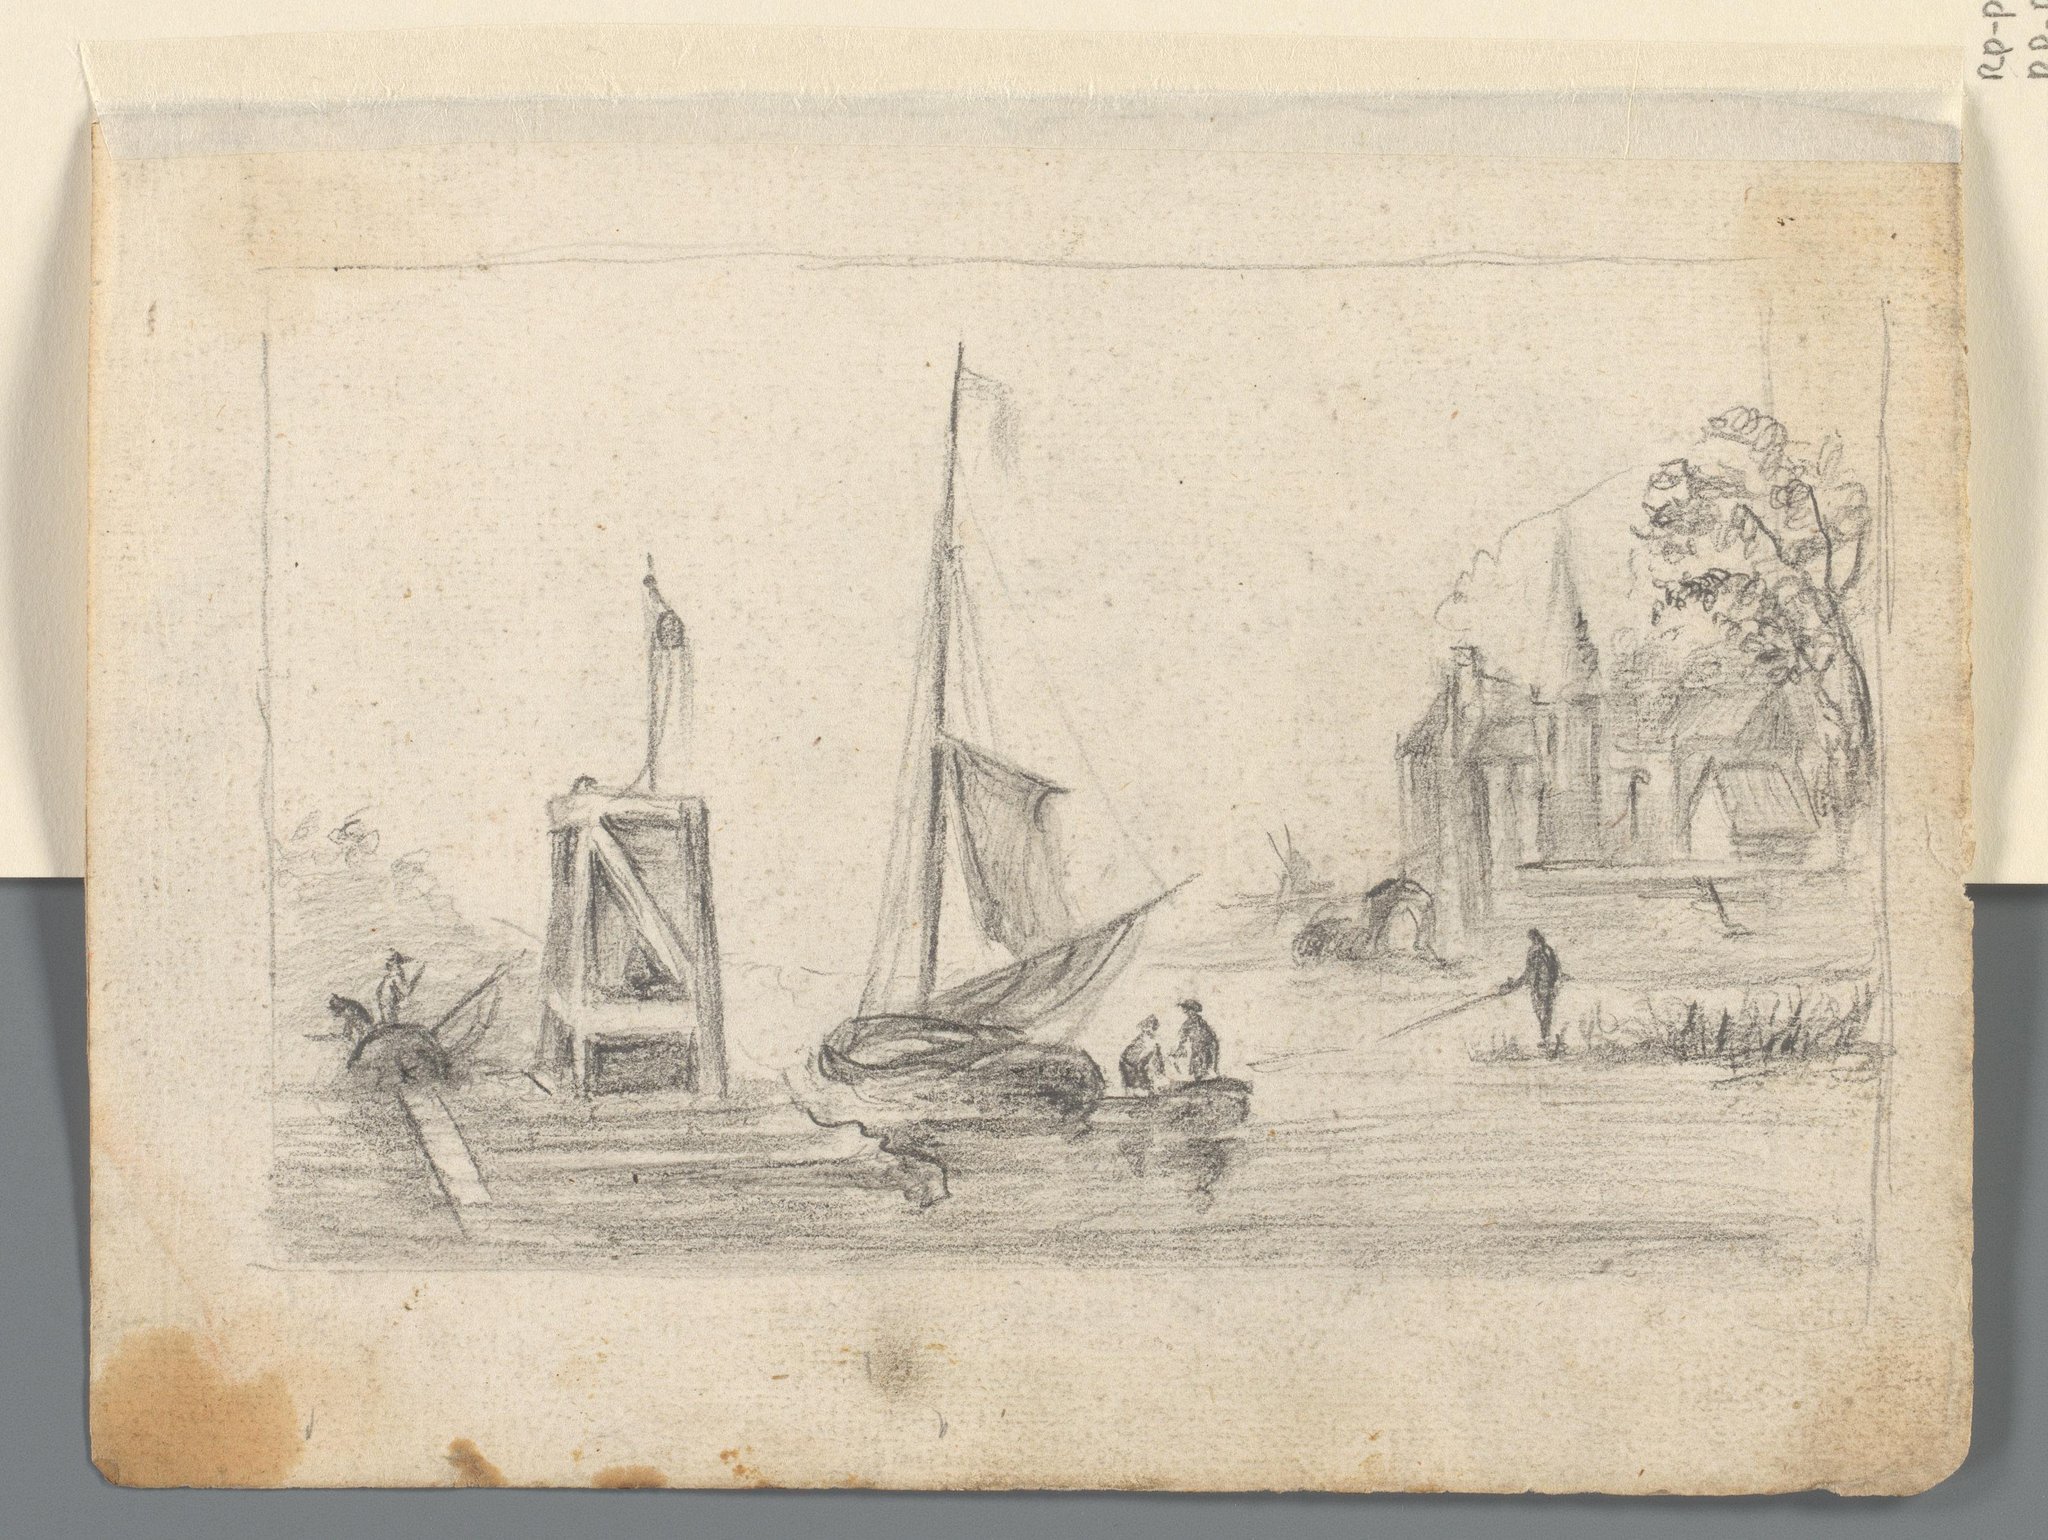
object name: drawing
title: Landschap met een aangemeerde zeilboot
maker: Anonymous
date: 1750-1820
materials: paper, pencil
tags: sailing-ship, sailing-boat, landscapes with waters, waterscapes, seascapes (in the temperate zone) (+ landscape with figures, staffage)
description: Een zeilboot met neergelaten zeil ligt aangemeerd. Daarnaast twee figuren in een kleinere boot. Een kerk en een visser staan rechts.